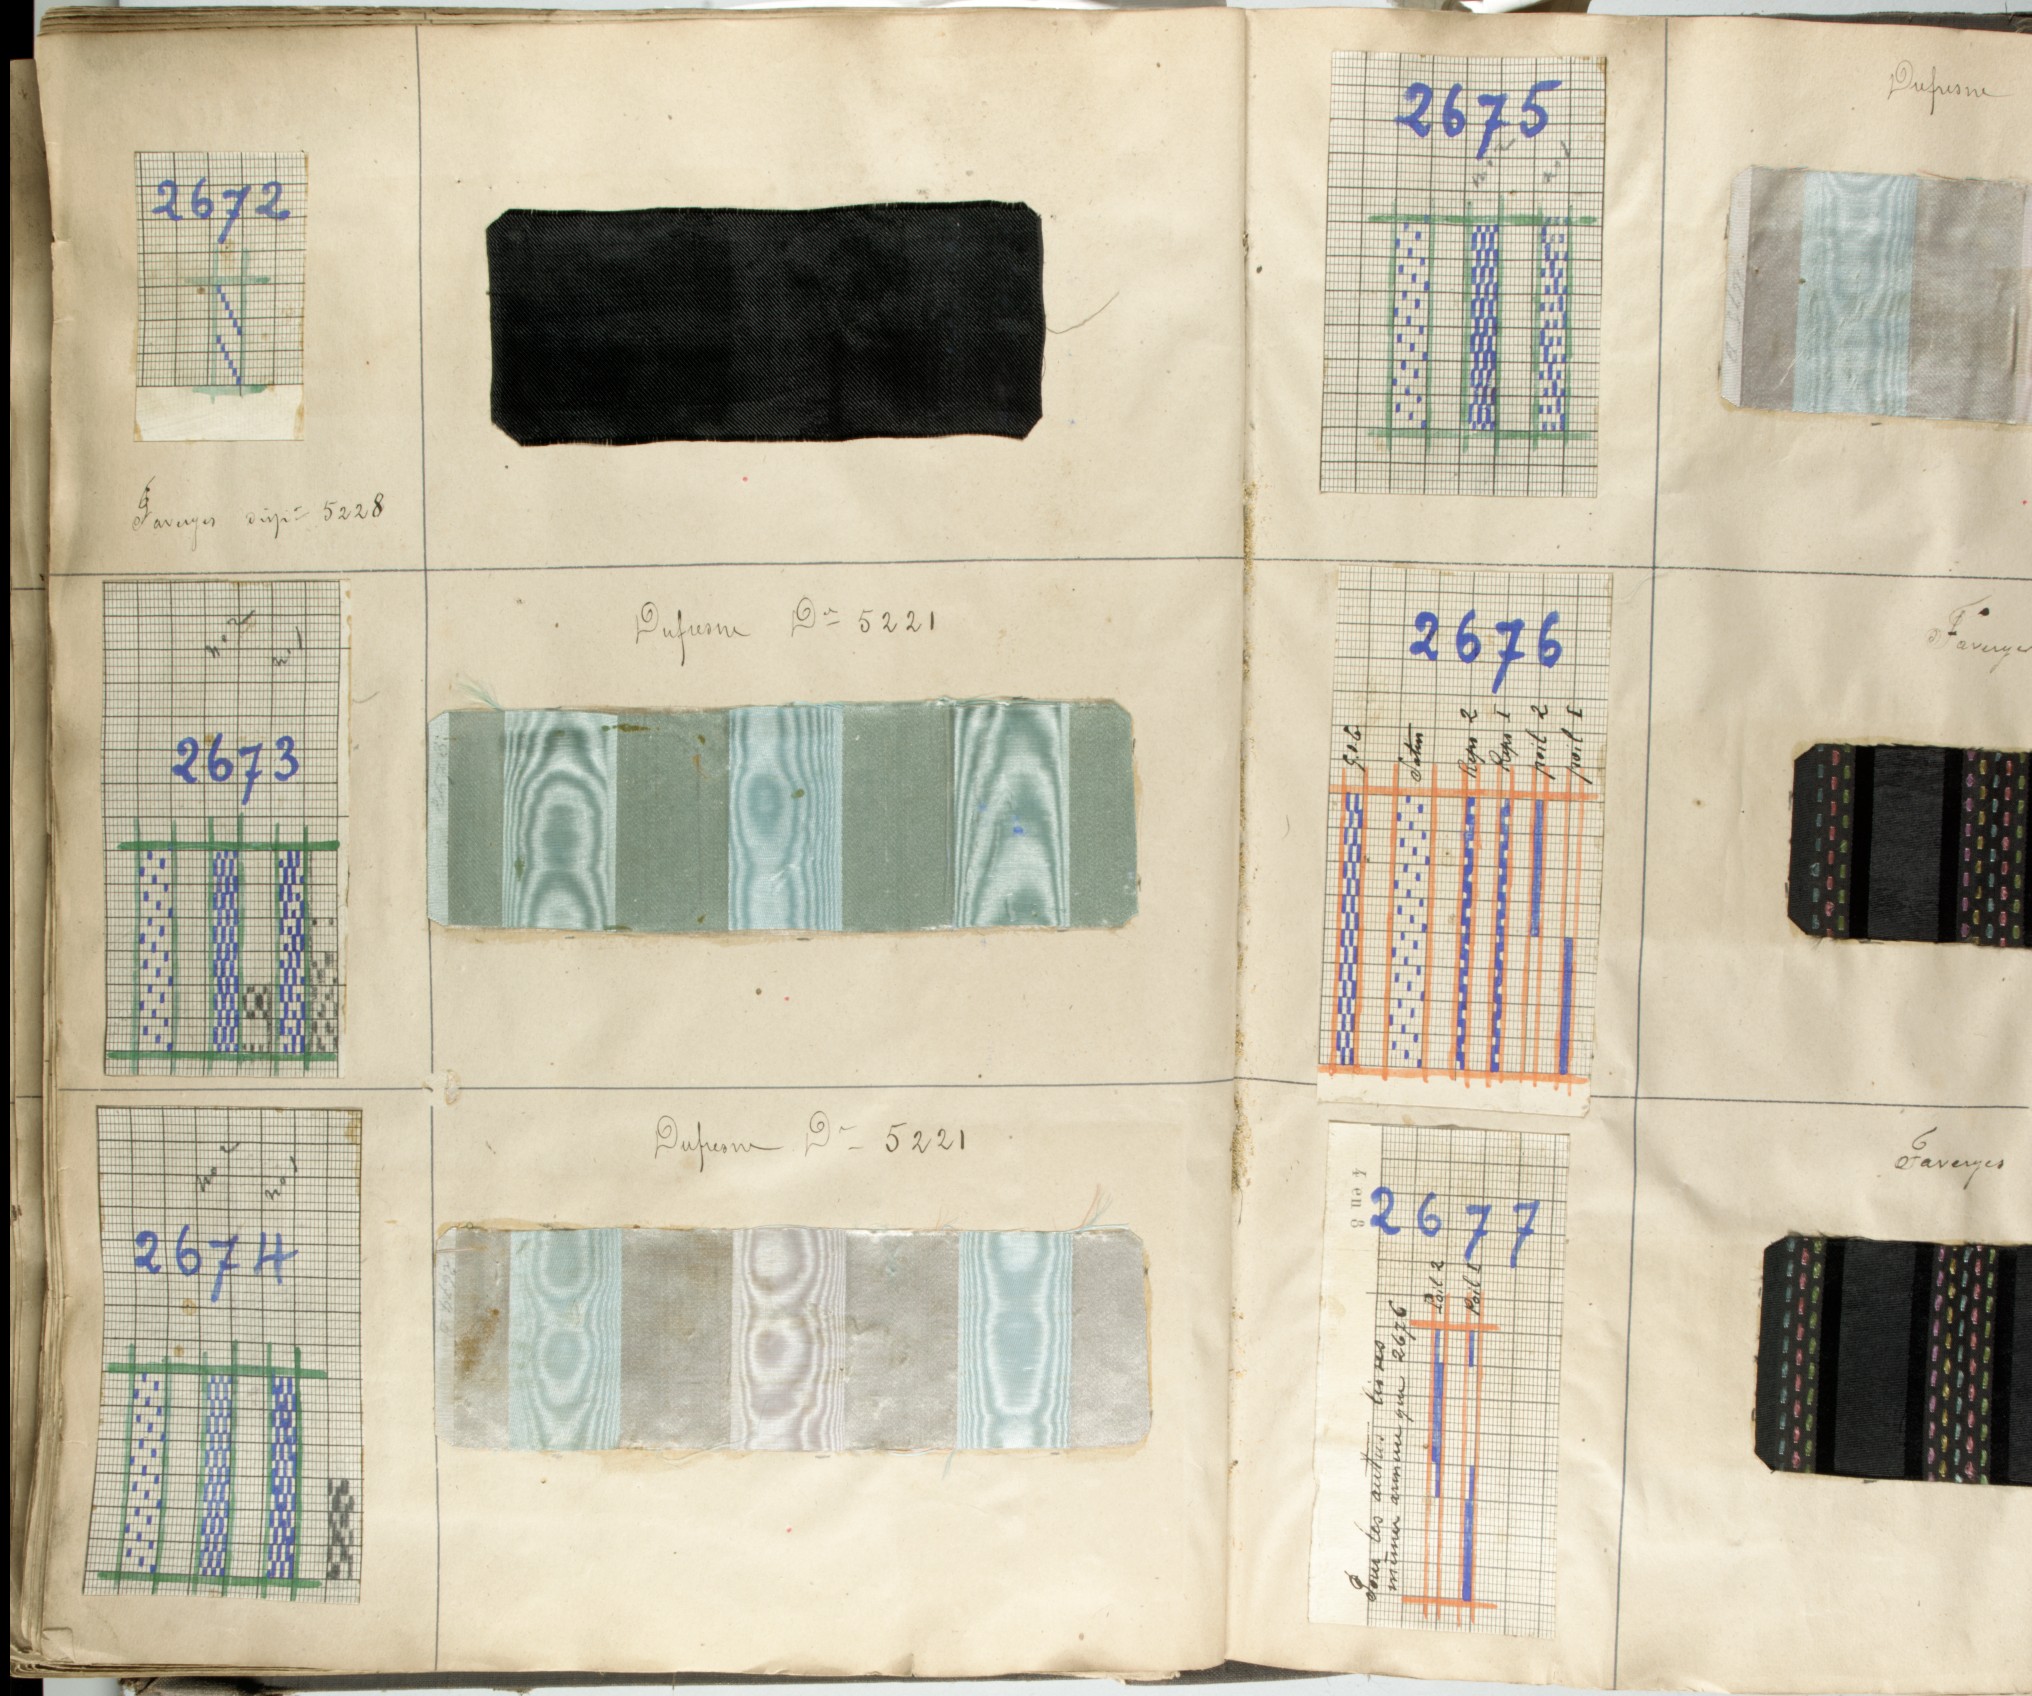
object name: sample book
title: Textile Sample Book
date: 1890-1891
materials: silk